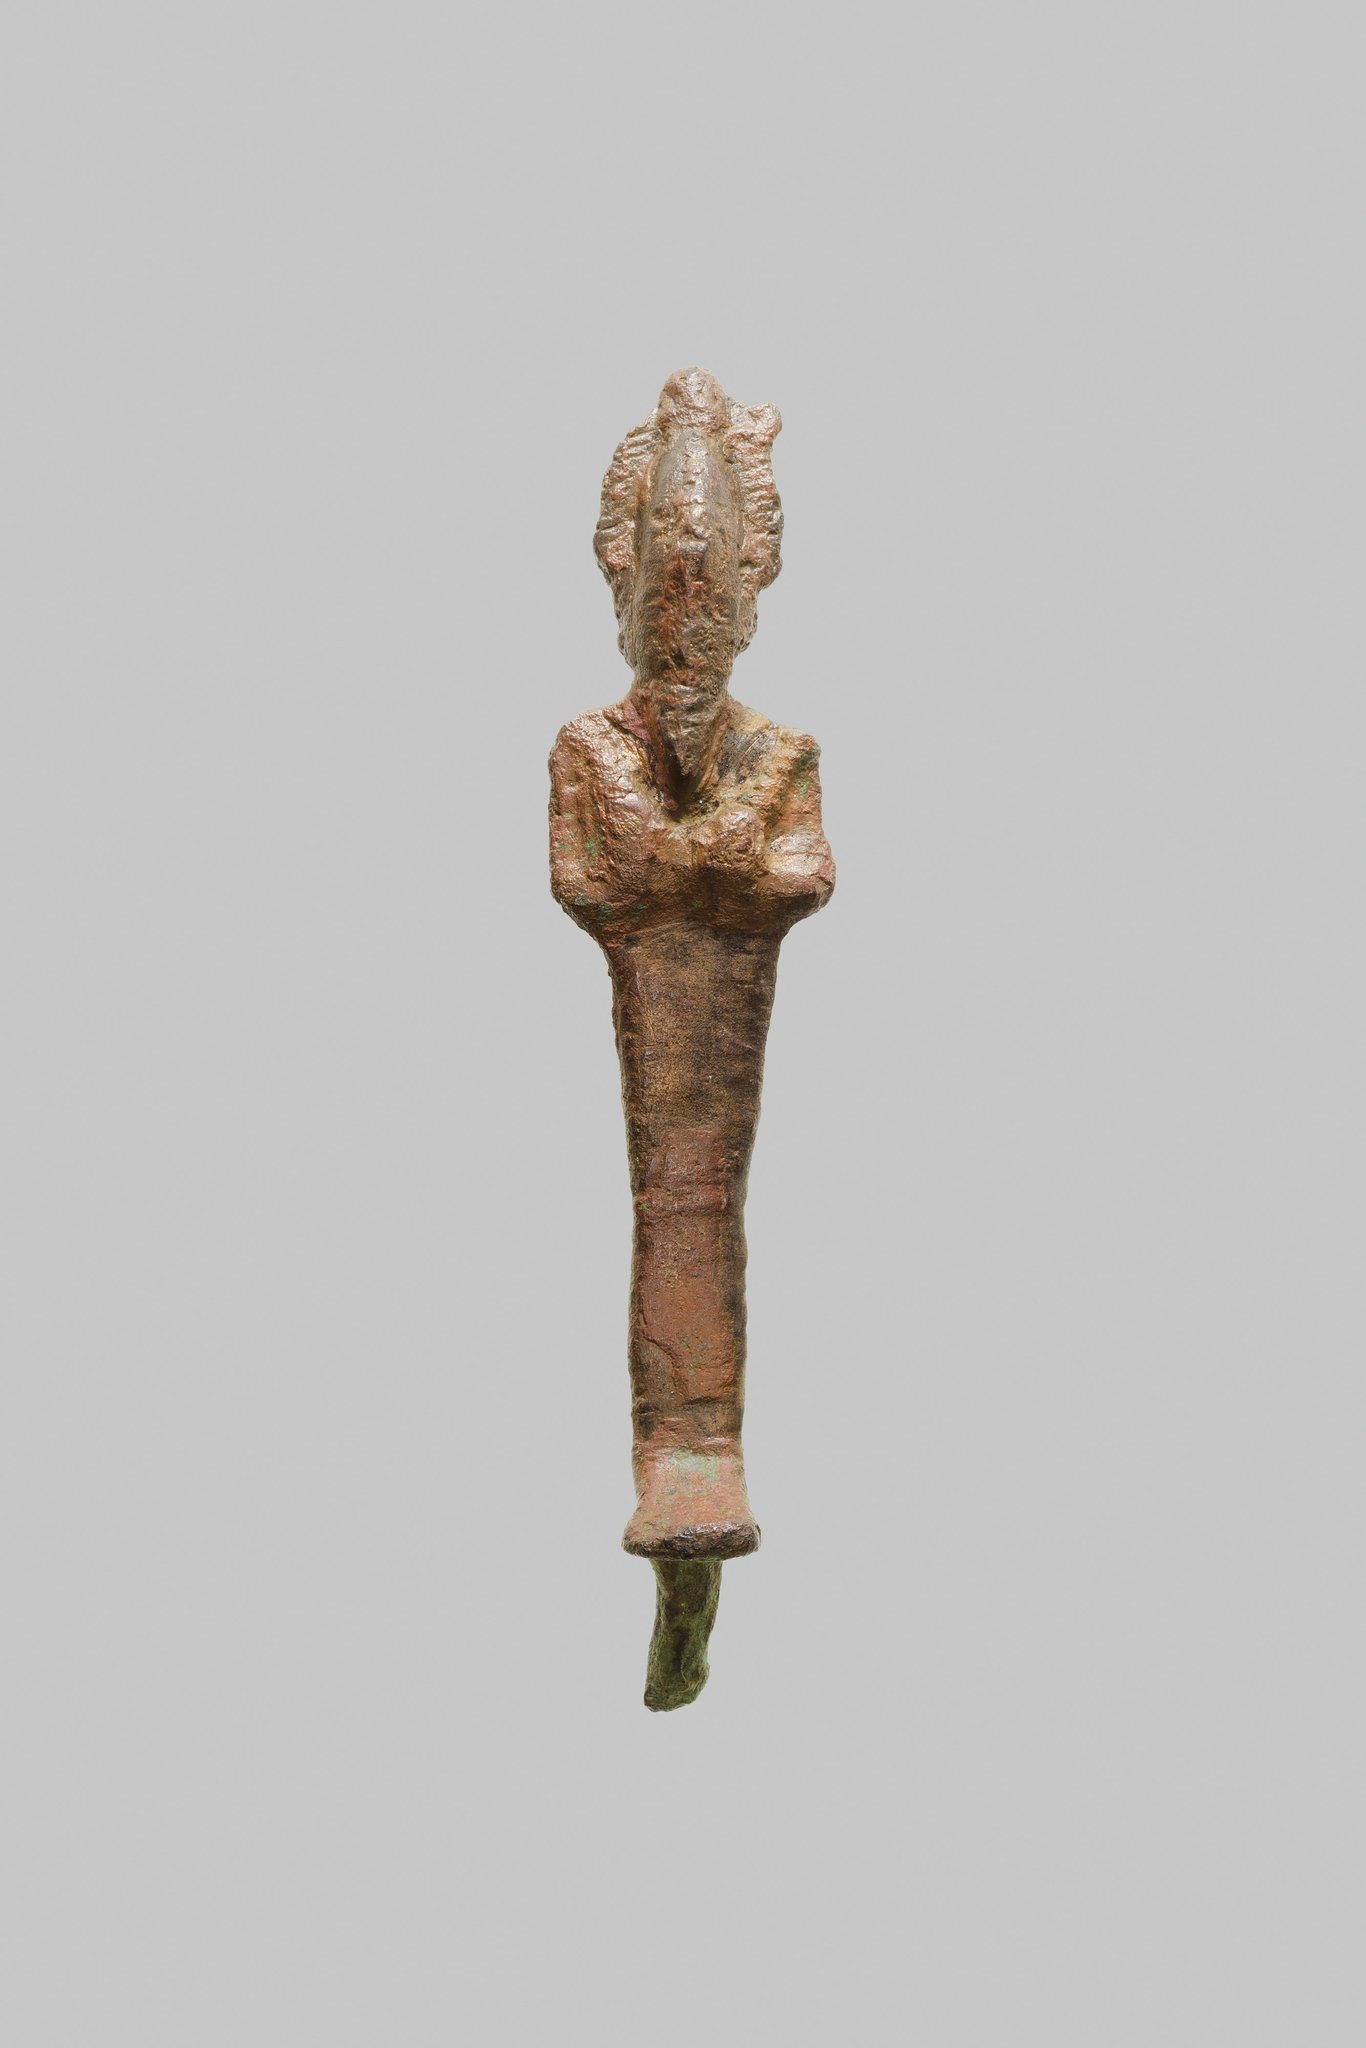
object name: statuette, osiris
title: Statuette of Osiris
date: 712-30 BCE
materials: bronze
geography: egypt